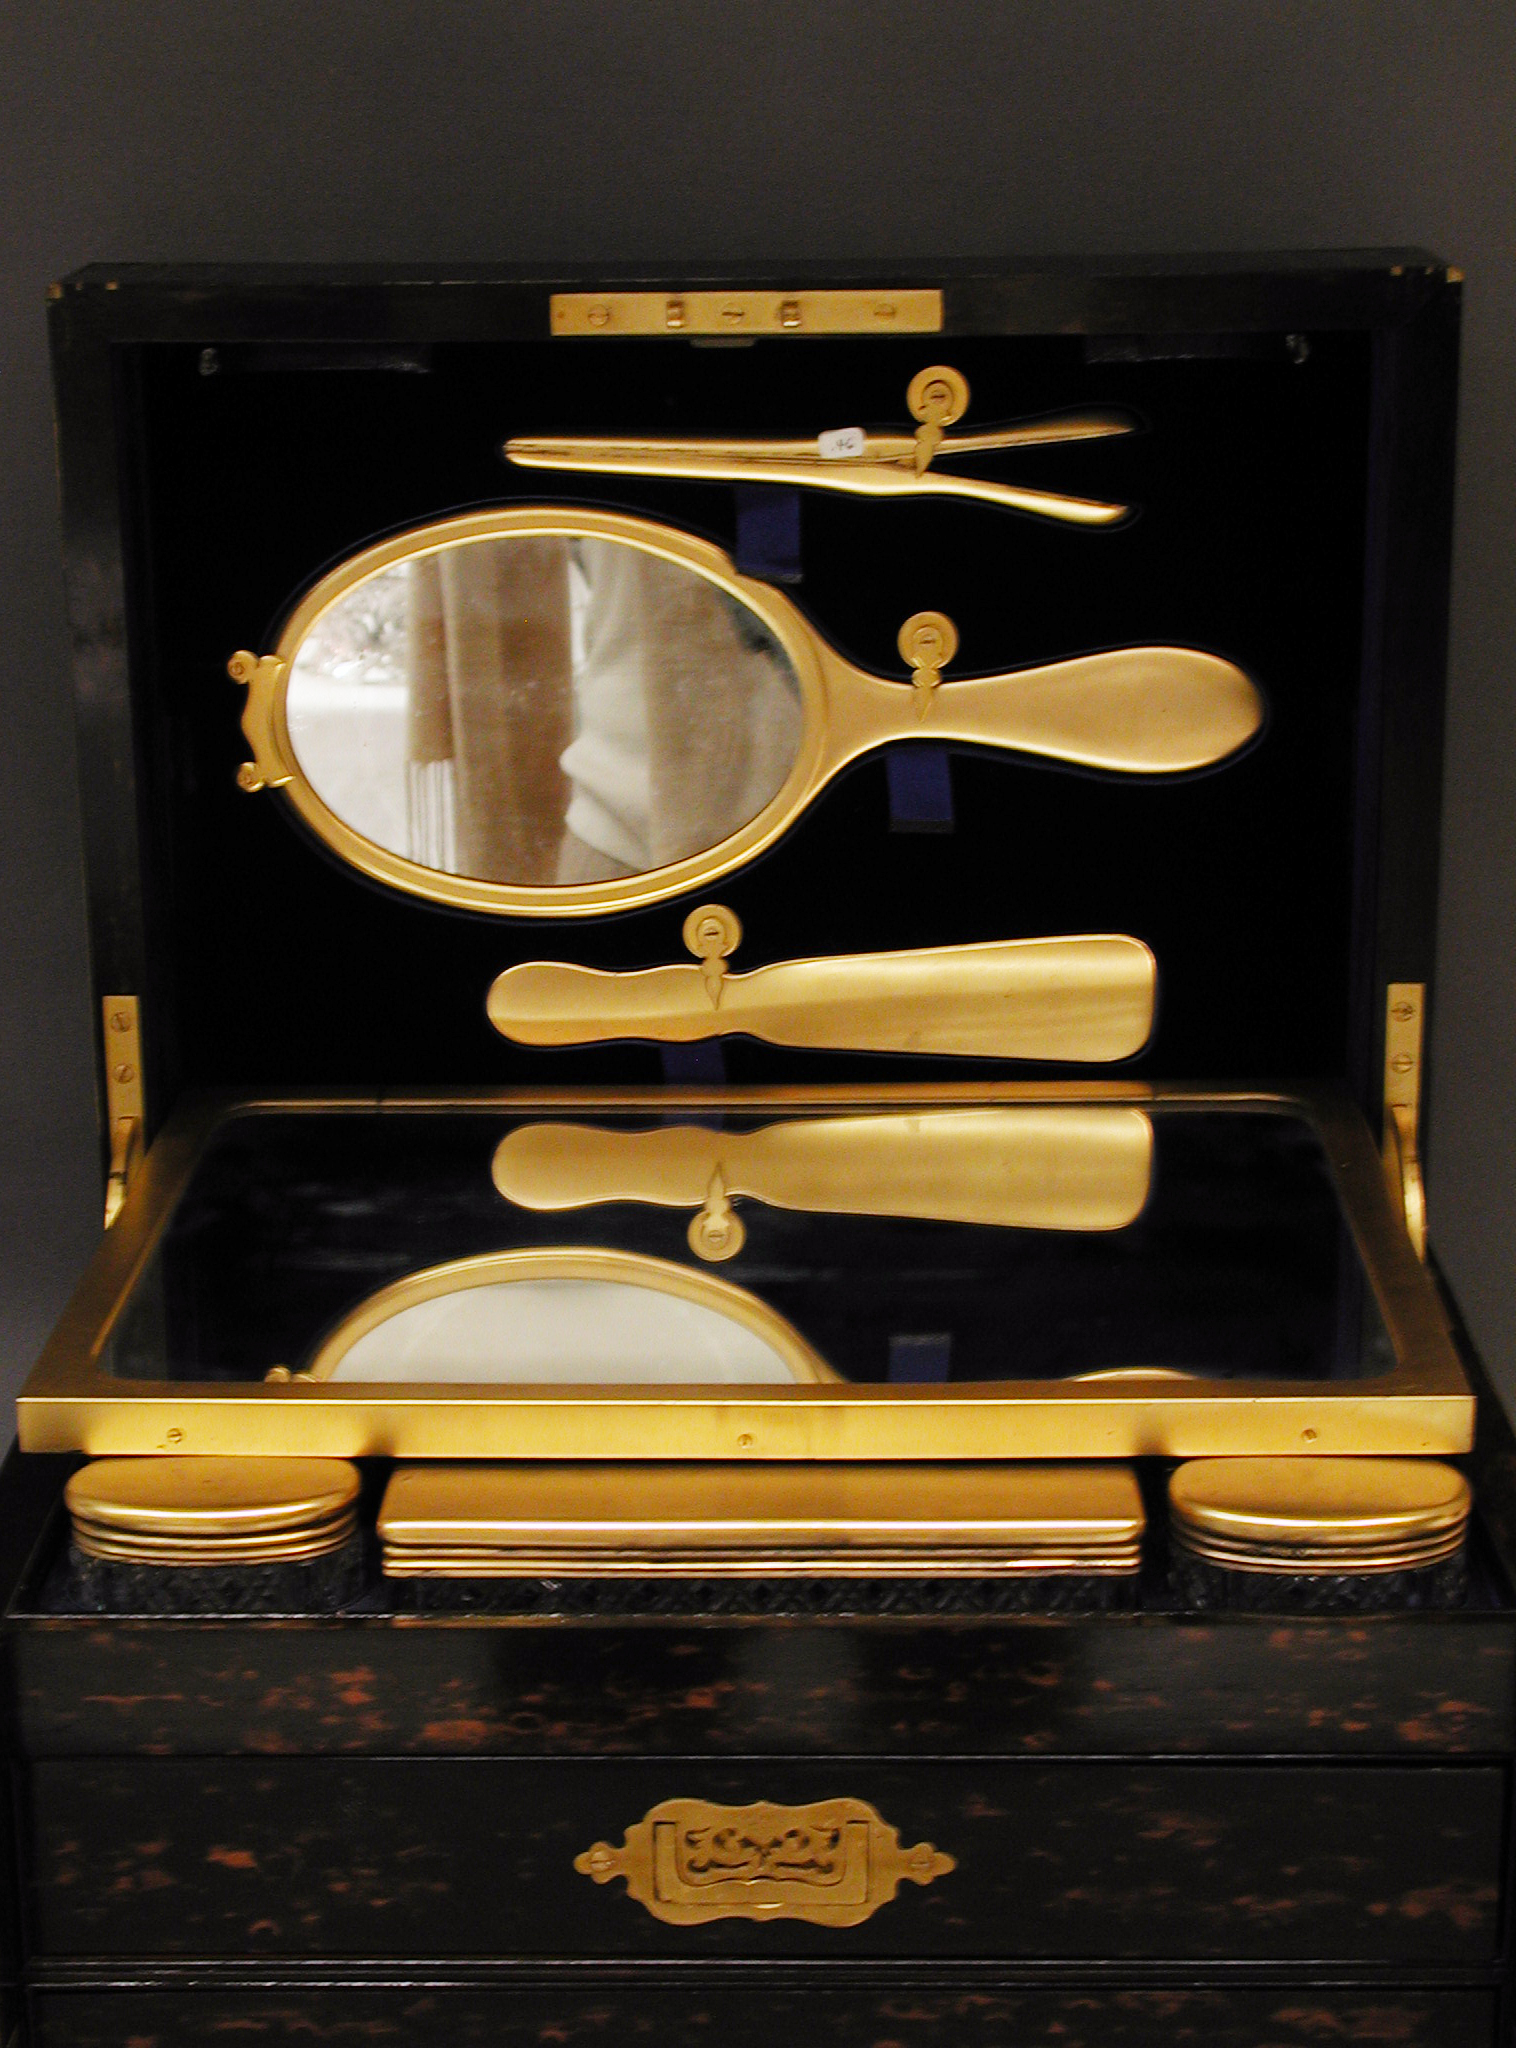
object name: shoe horn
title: Shoehorn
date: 1874-1875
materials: silver